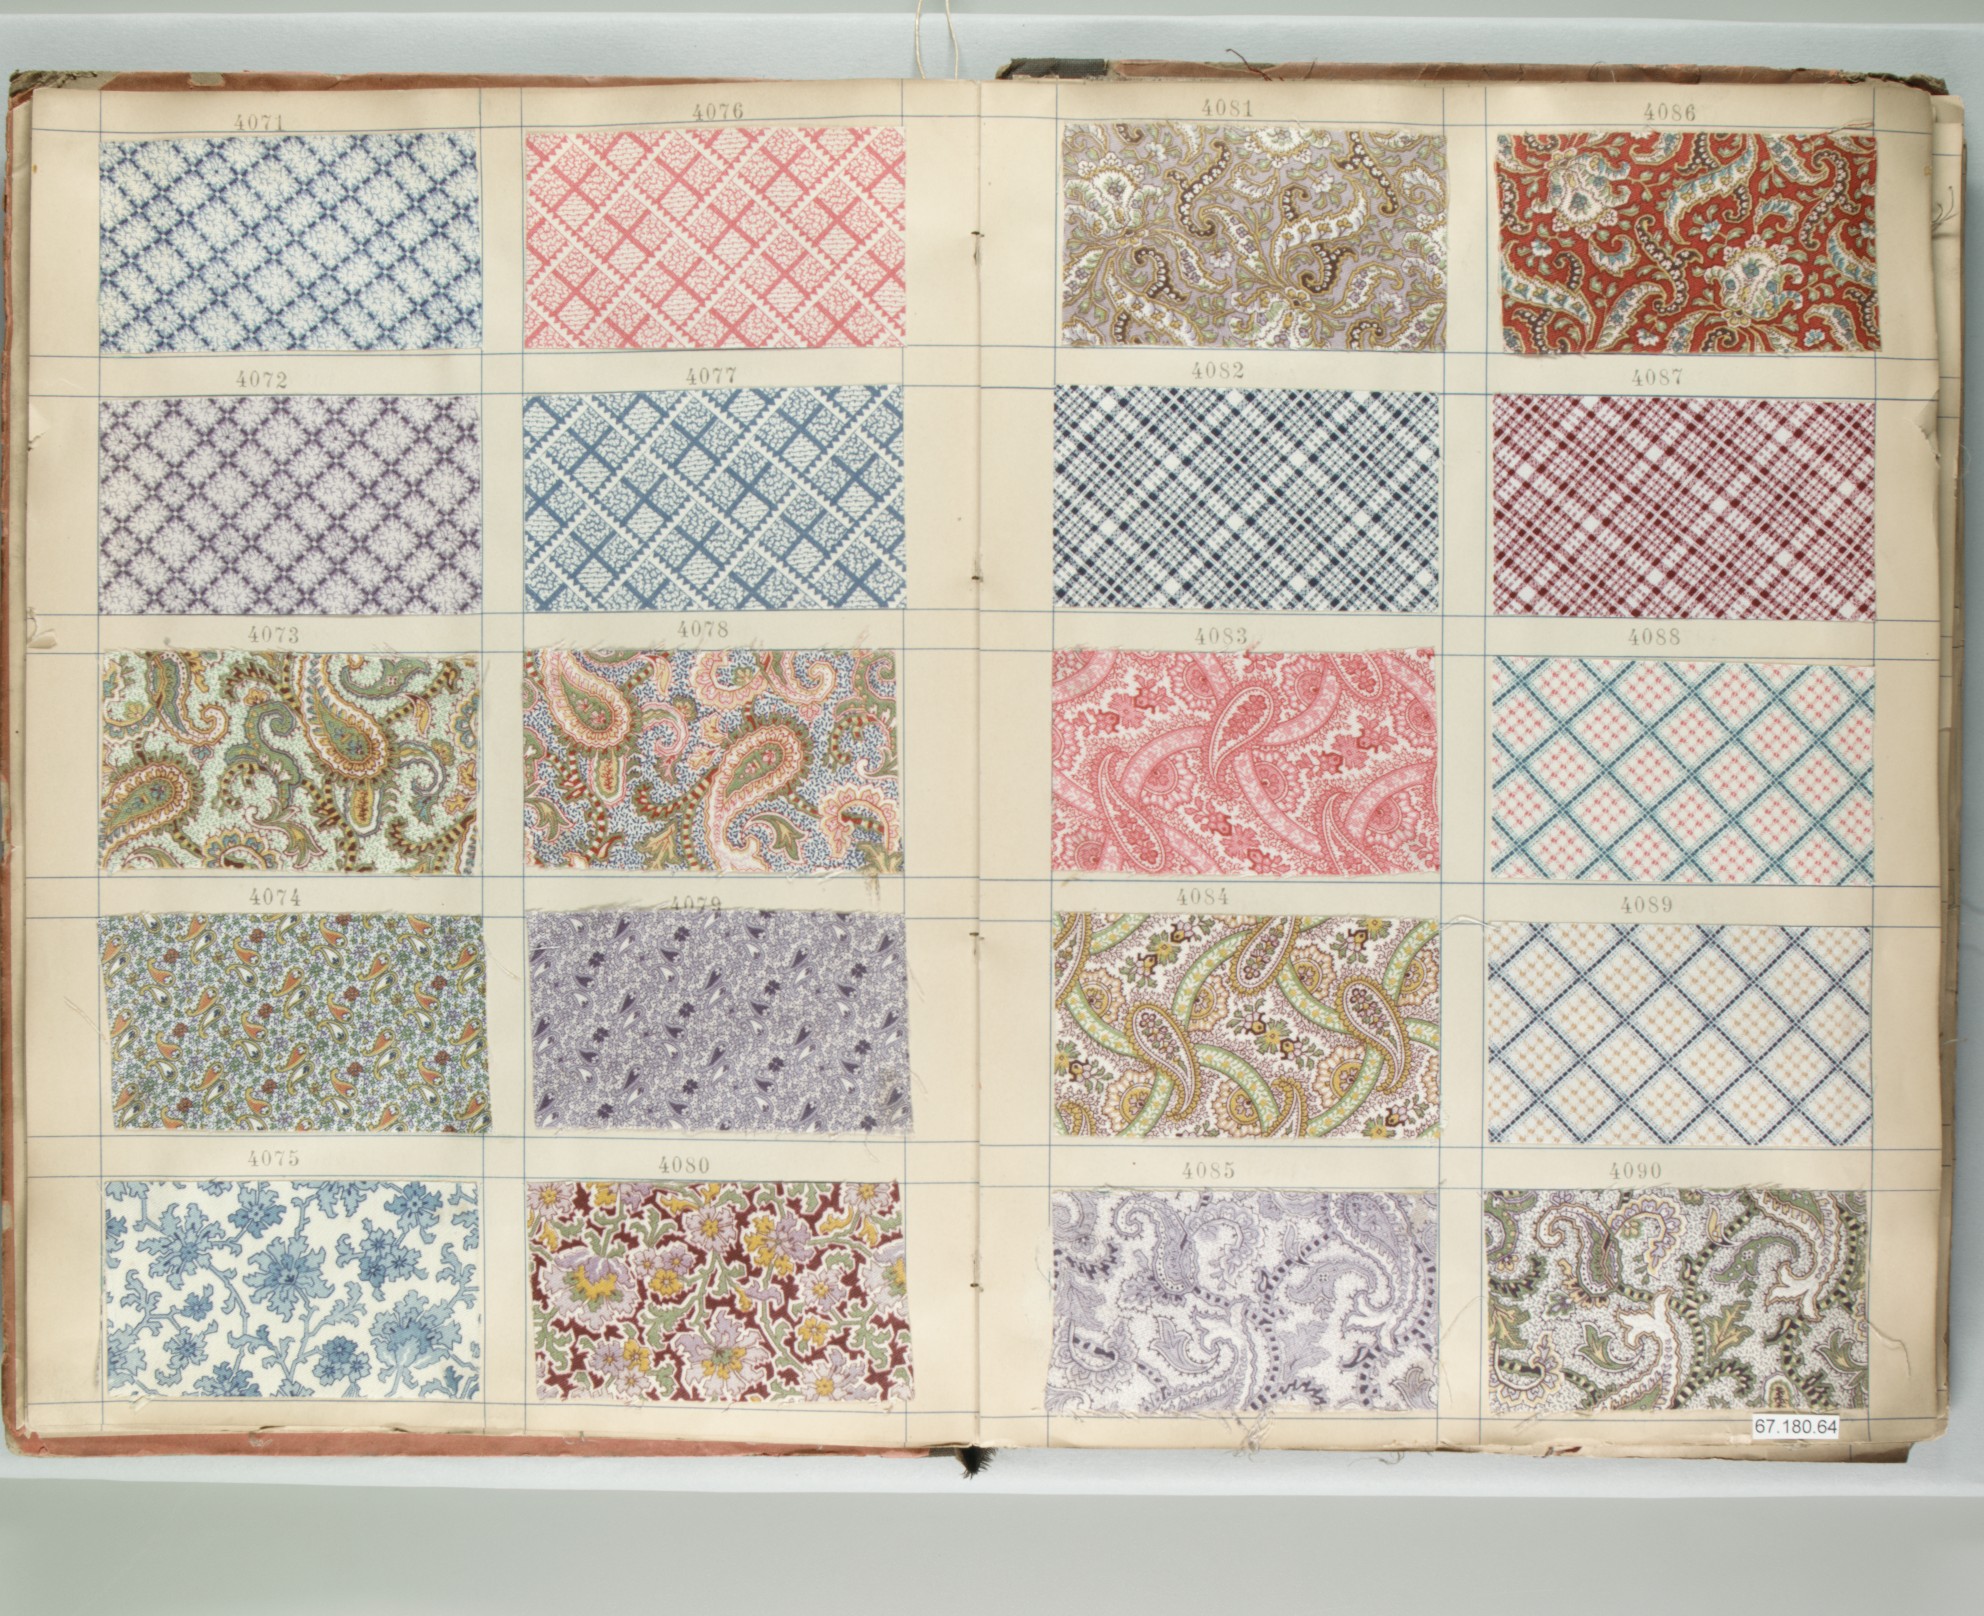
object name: sample book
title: Textile Sample Book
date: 1850-1900